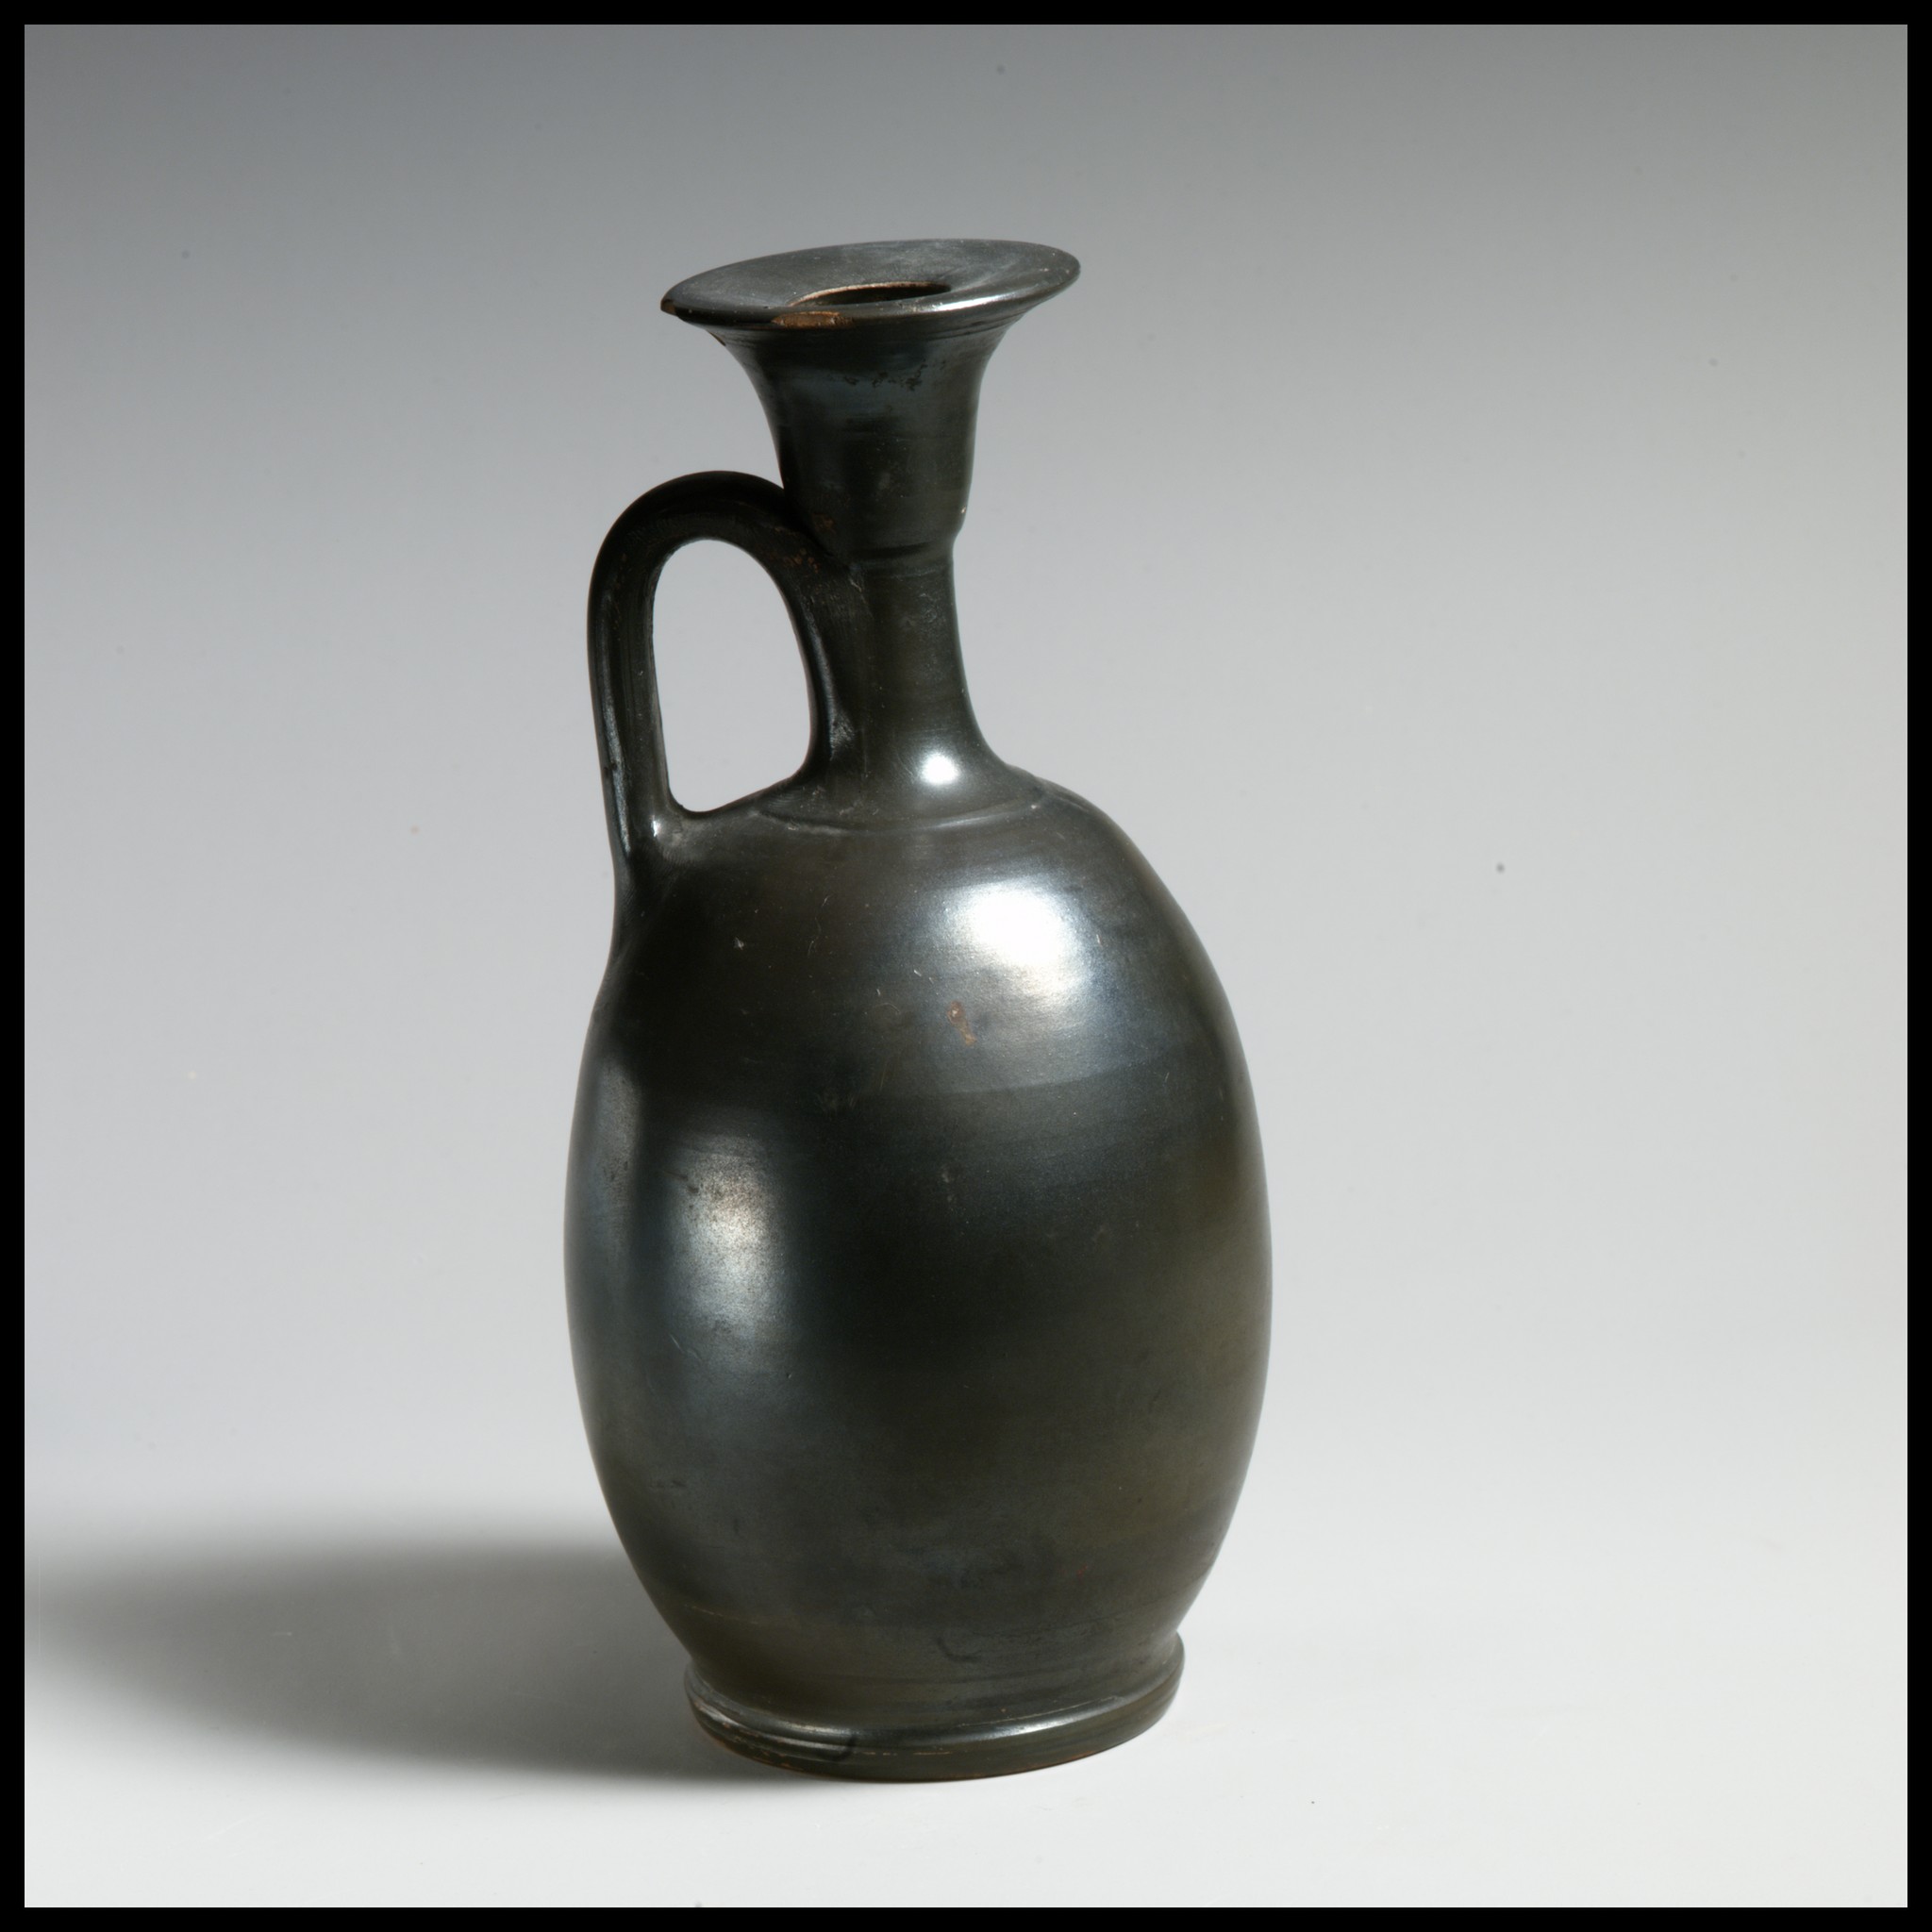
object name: lekythos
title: Terracotta lekythos (oil flask)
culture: greek or south italian or campanian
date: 400-301 BCE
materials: terracotta